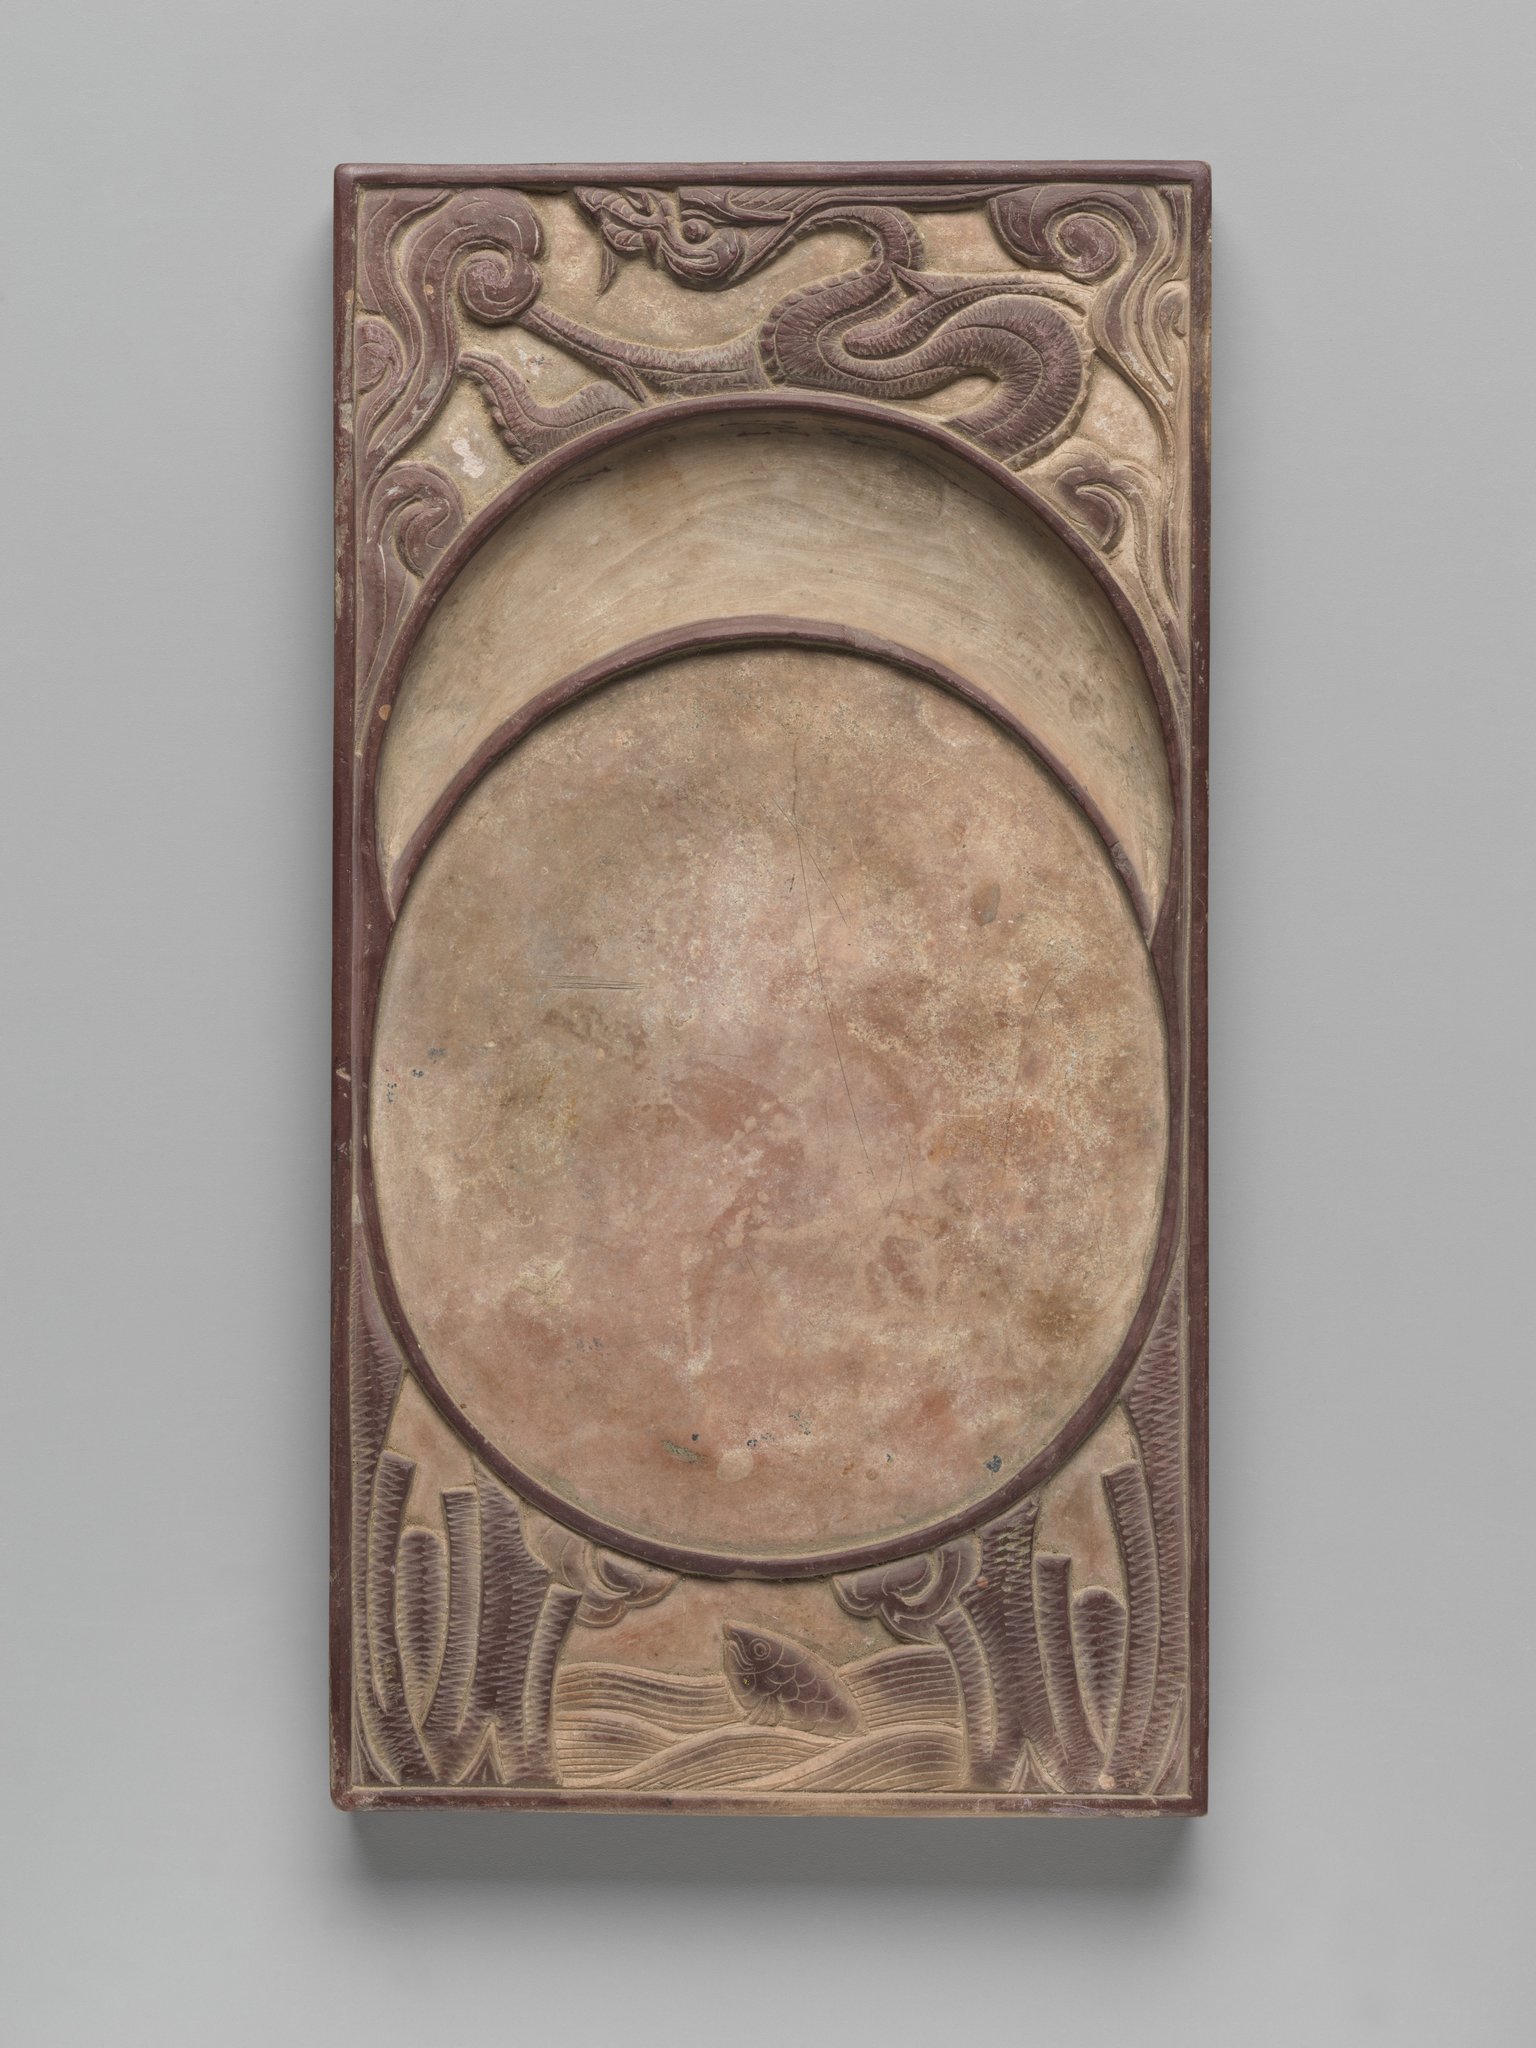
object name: inkstone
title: Inkstone with dragon and carp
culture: chinese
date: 1301-1400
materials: stoneware